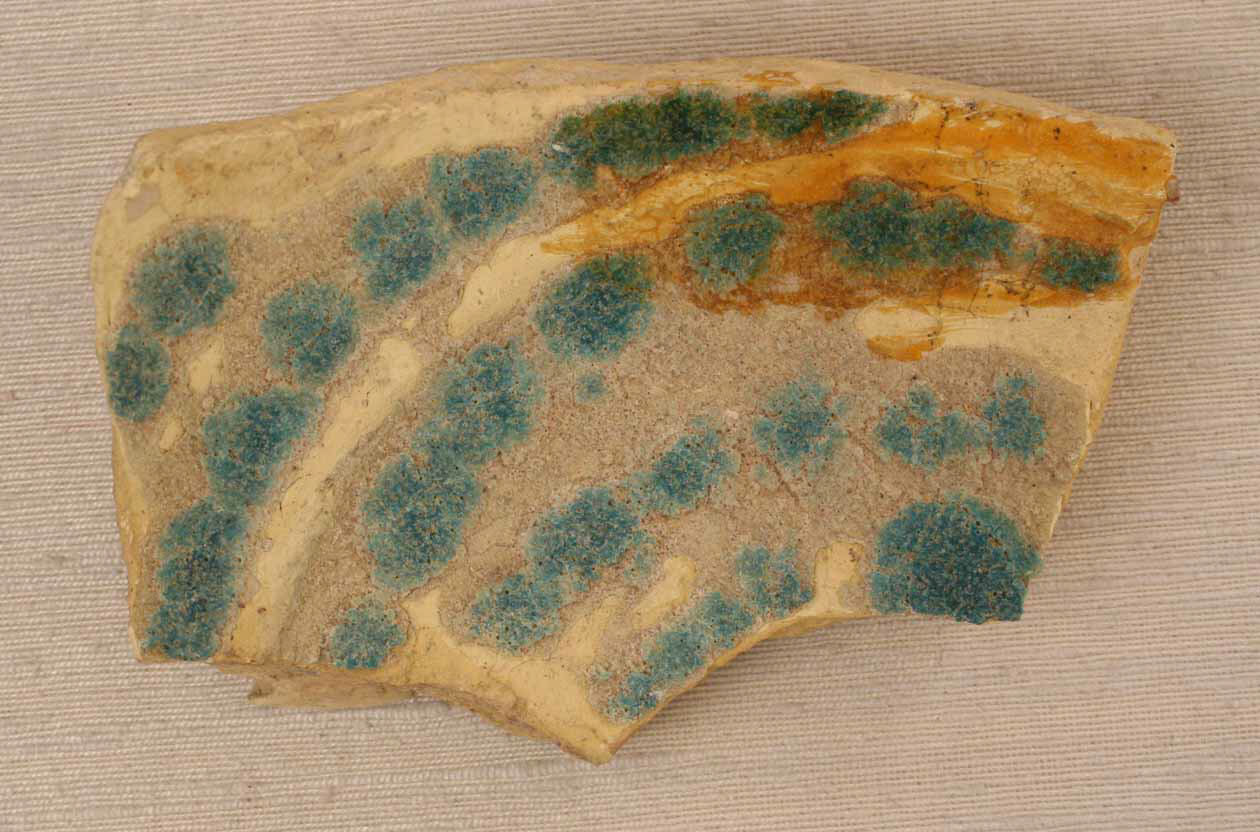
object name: fragment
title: Ceramic Fragment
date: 801-1000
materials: earthenware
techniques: glazing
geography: saudi arabia